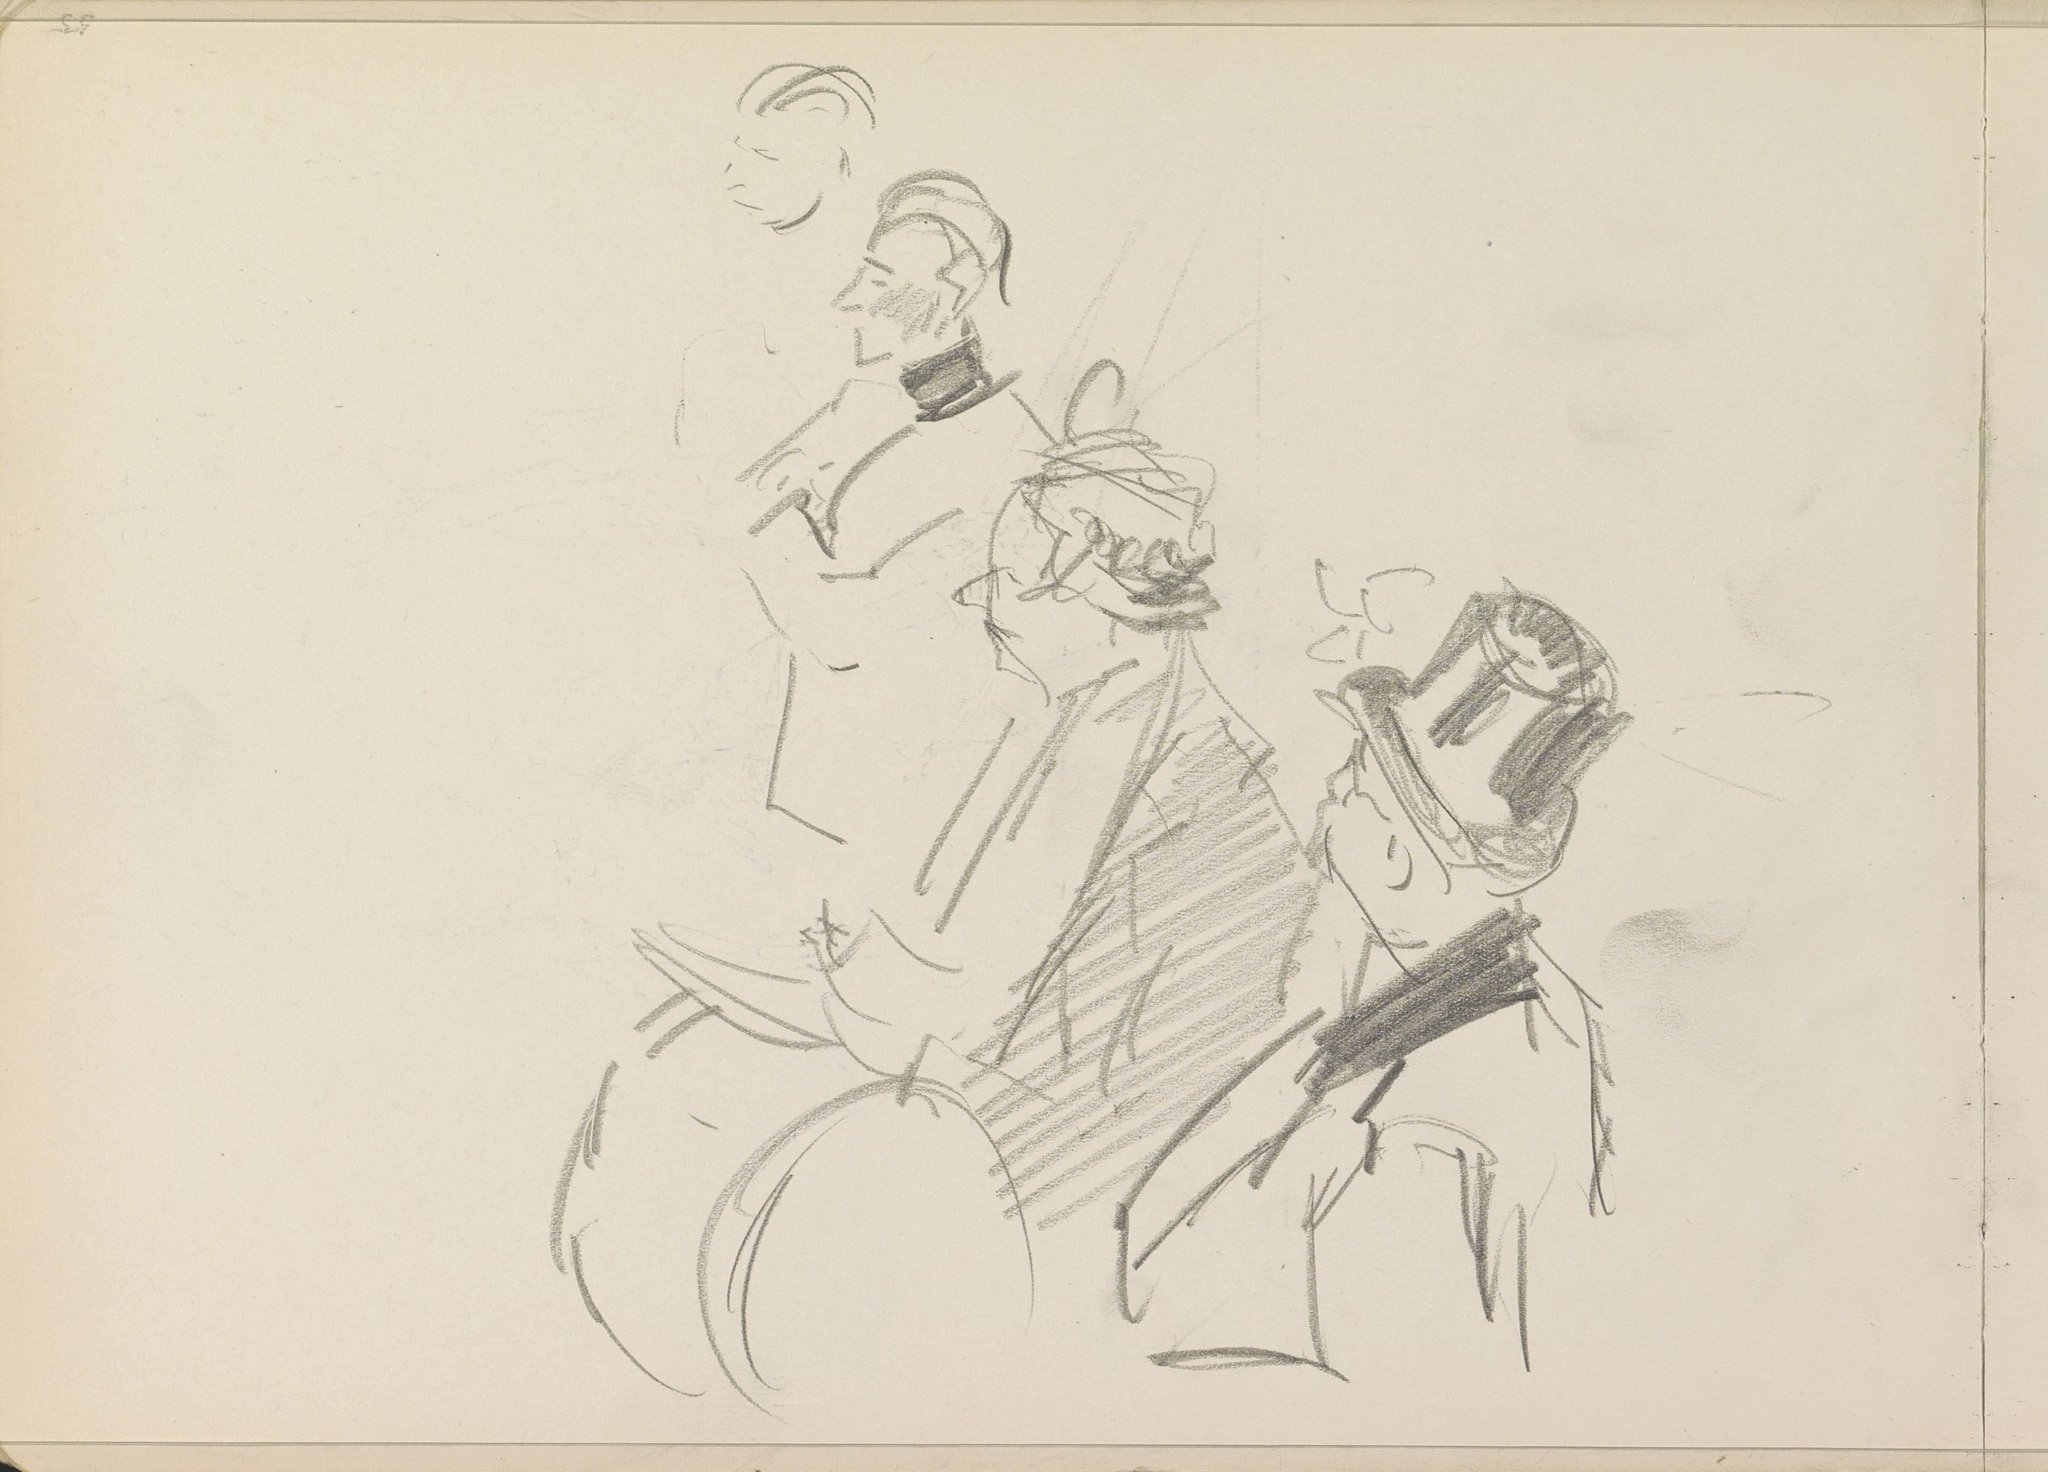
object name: sketchbook leaf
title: Mannen op een rij, mogelijk muzikanten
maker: isaac israels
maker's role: draughtsman, painter, print maker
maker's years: 1865-1934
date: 1915-1934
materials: paper, pencil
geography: the hague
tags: musician, adult man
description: Blad 12 verso uit schetsboek VI met 33 bladen.